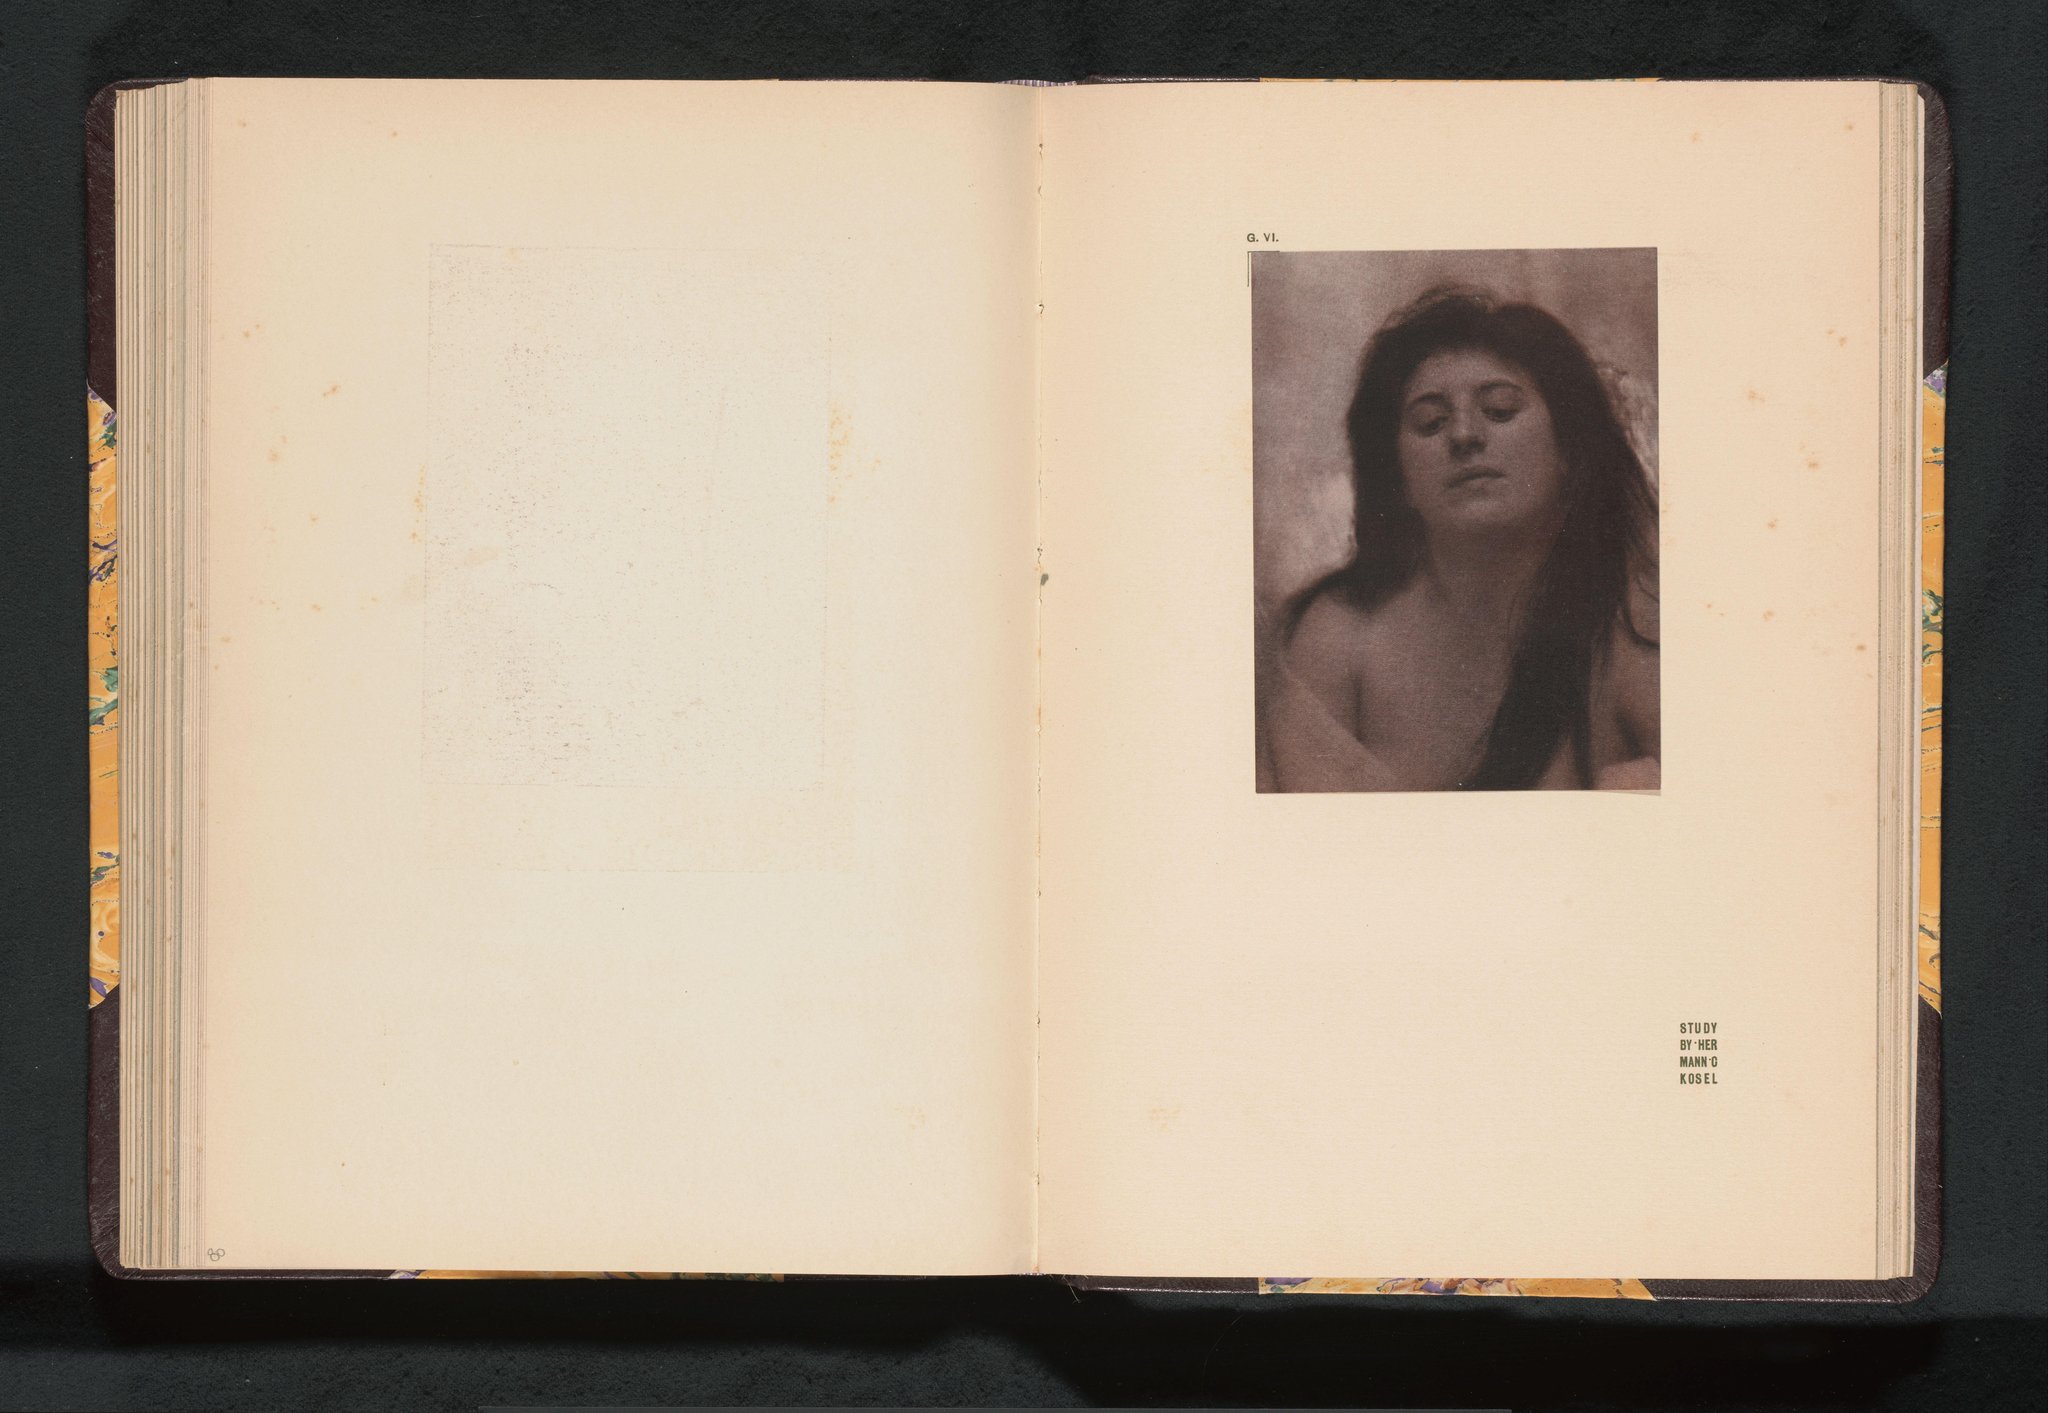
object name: photomechanical print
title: Portretstudie van een onbekende vrouw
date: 1900-1905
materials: paper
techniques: two-color autotype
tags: historical persons - bb - woman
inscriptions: inscription: ‘Study by Hermann C. Kosel’, inscription: ‘G. VI.’